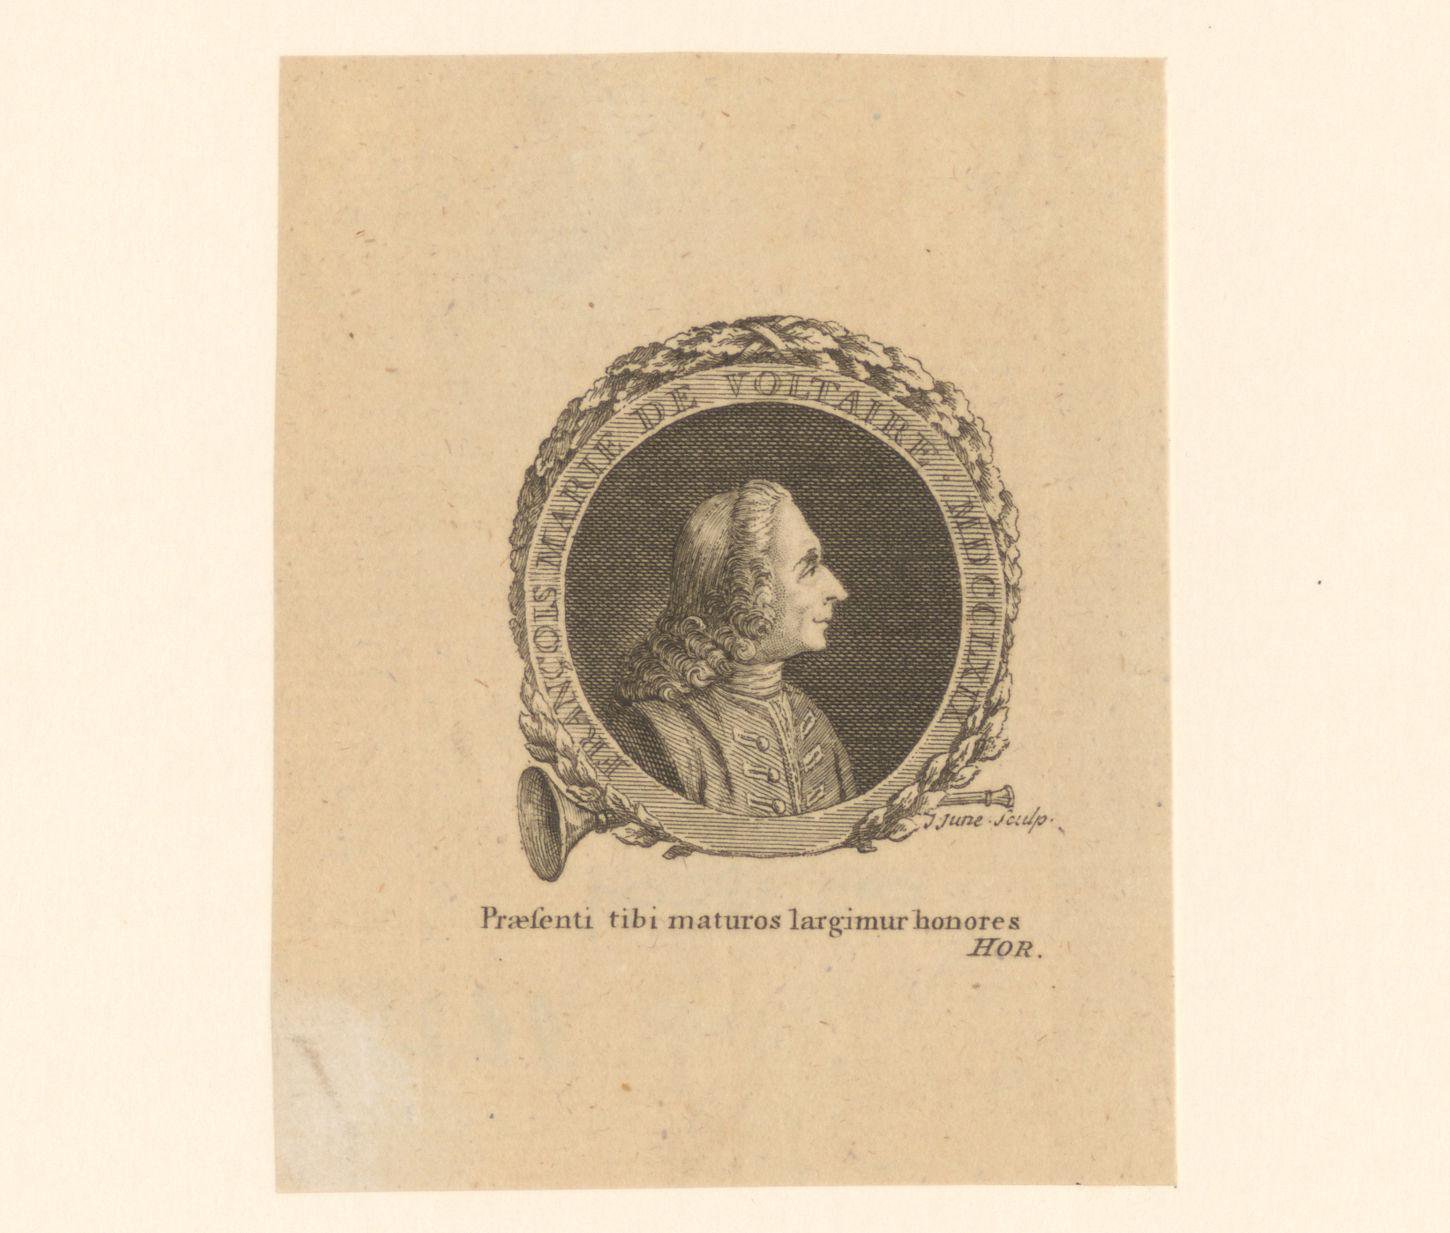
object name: print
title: Portret van Voltaire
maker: john june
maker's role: print maker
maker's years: 1740-1770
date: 1769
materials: paper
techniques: engraving, etching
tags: paris, voltaire, further education (+ portrait of teacher, professor), historical persons, portrait of a writer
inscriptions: collector's mark: Lugt 2228